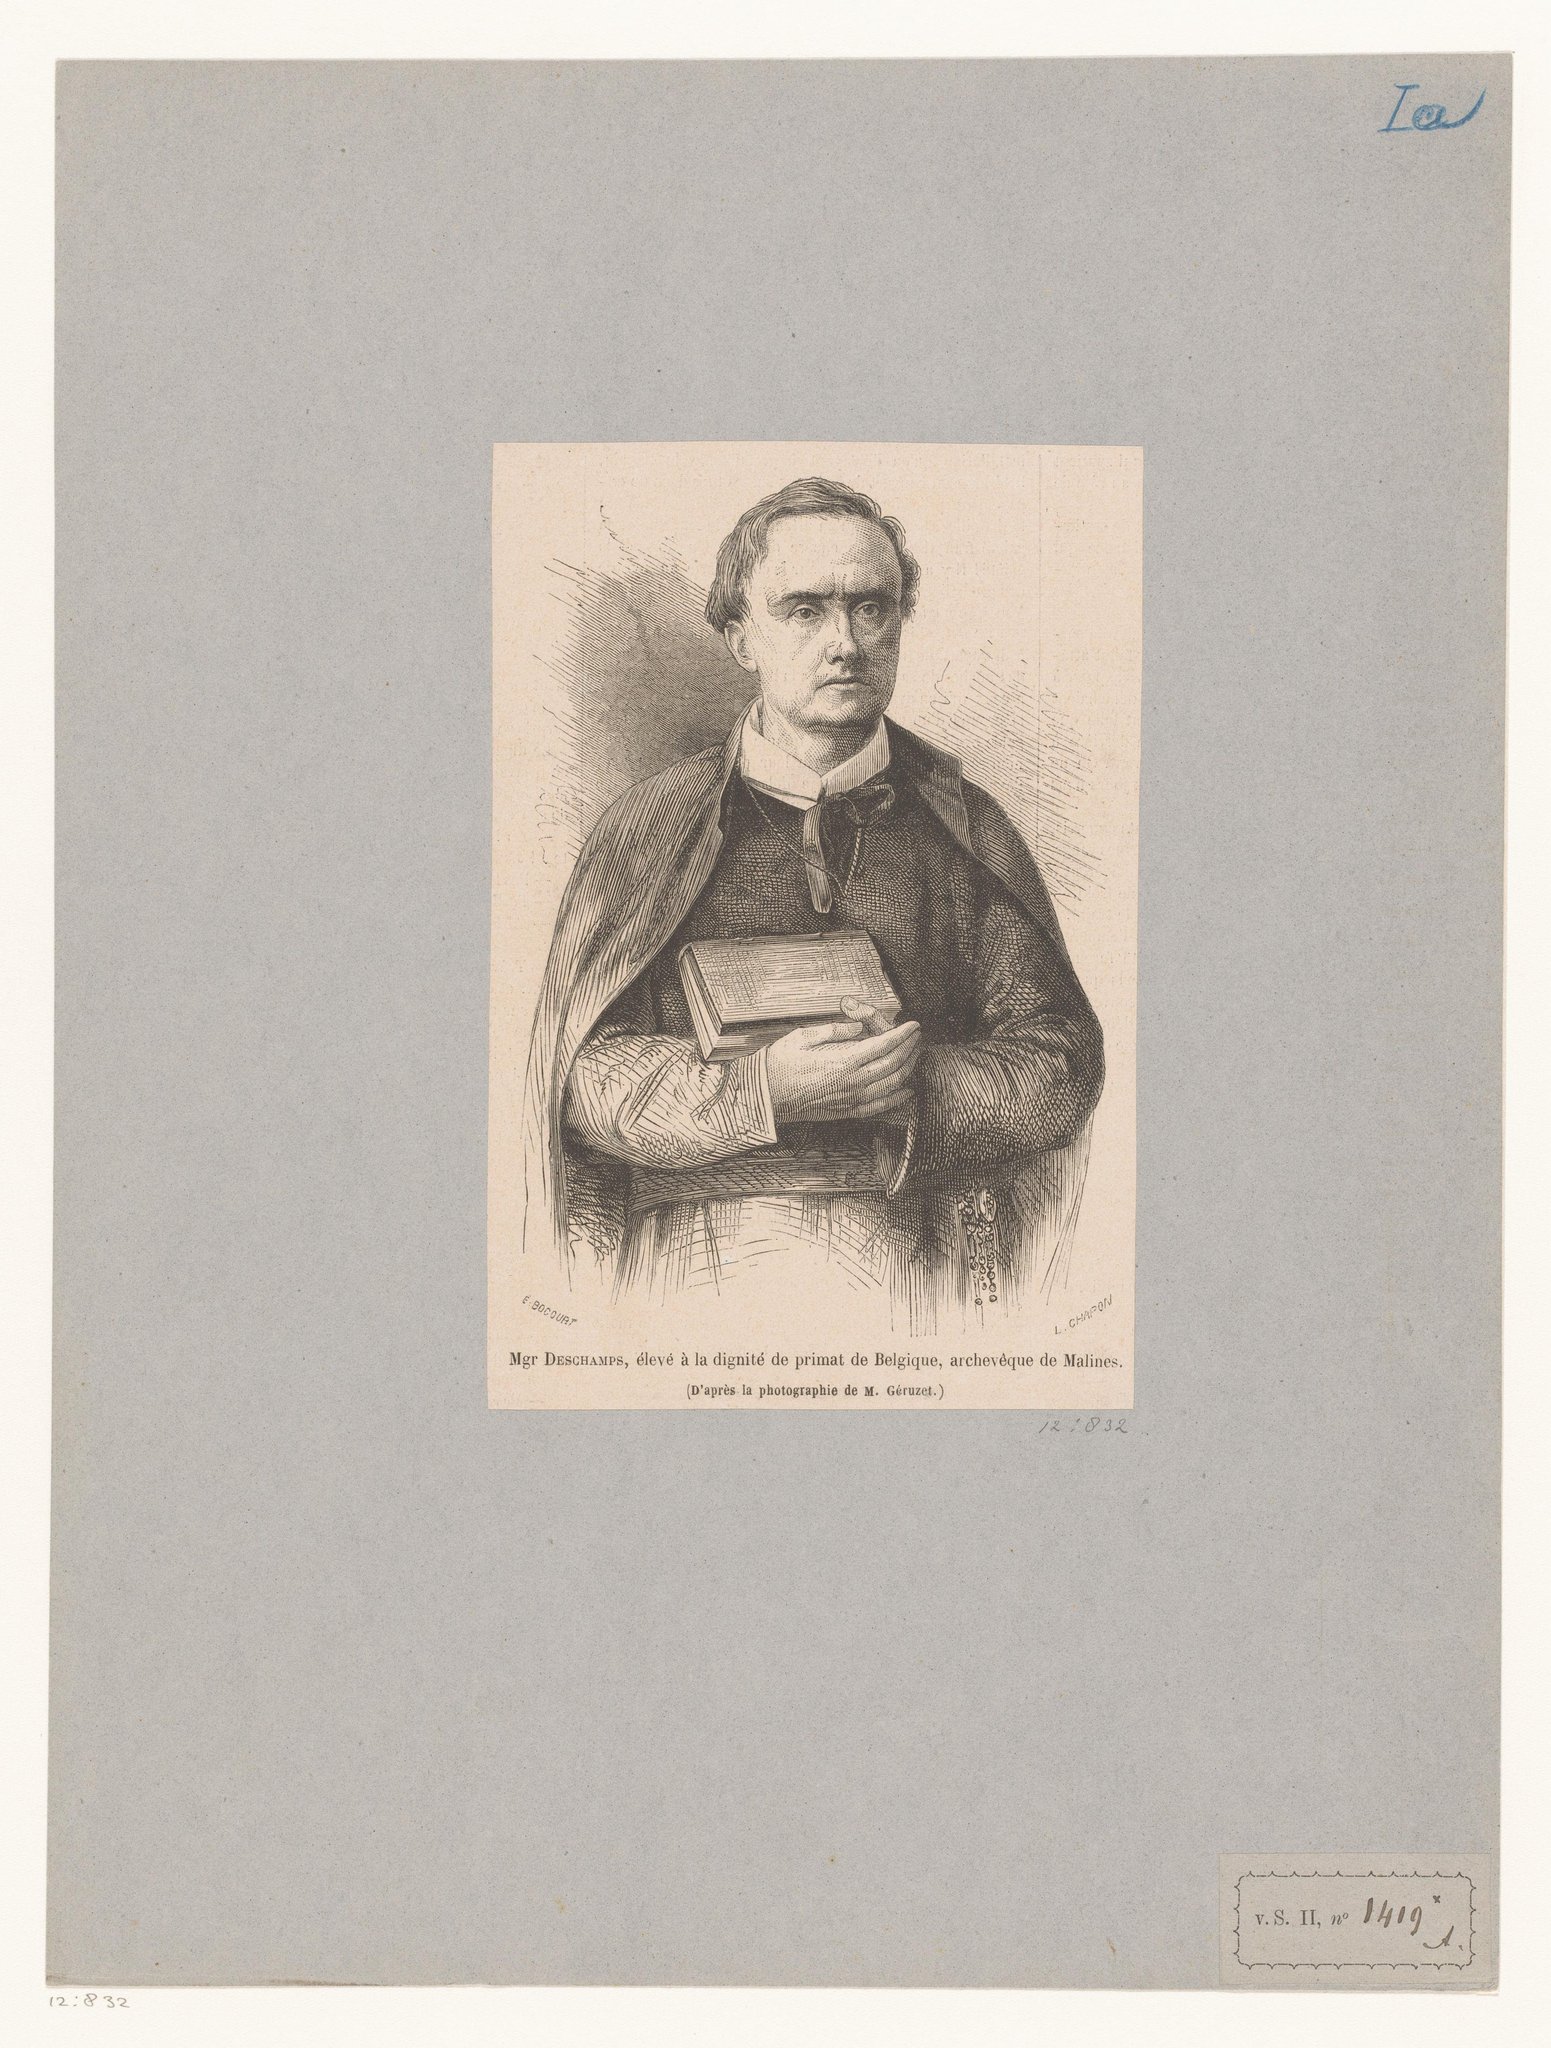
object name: print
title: Portret van Victor-Auguste-Isidor Deschamps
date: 1846-1900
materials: paper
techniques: letterpress printing, engraving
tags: mechelen, adult man, historical persons, book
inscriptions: label: ‘v.S. II, no 1419* A’, collector's mark: Lugt 2228